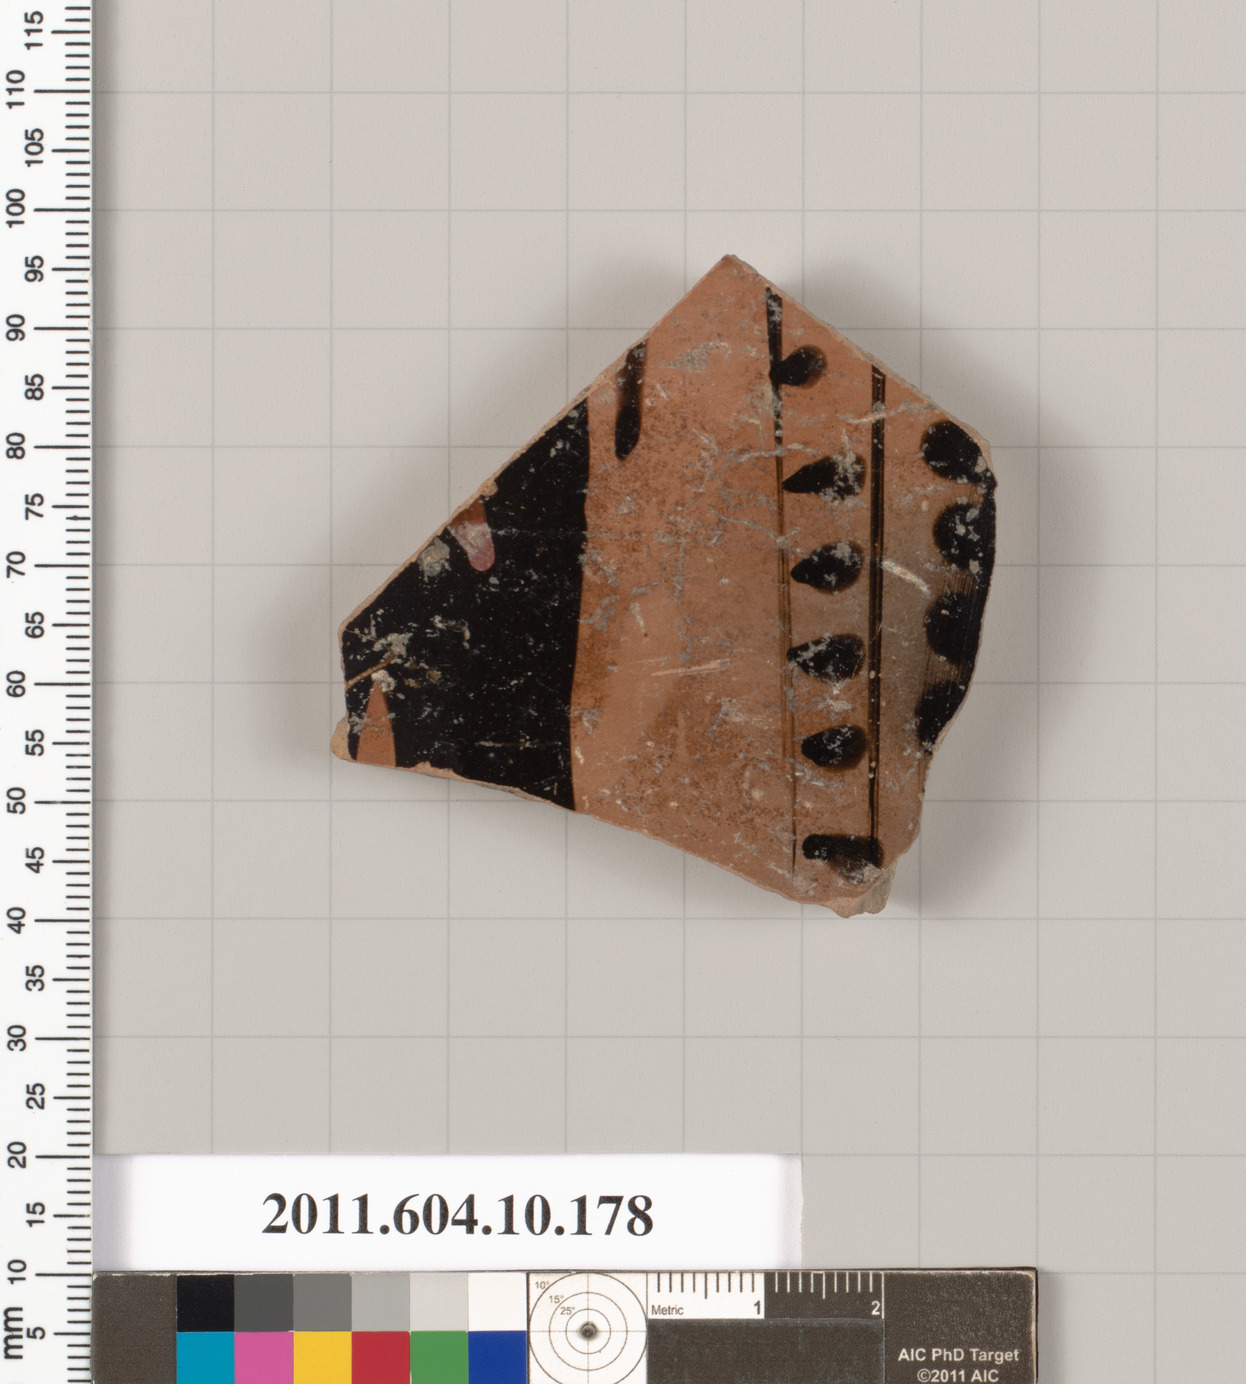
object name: krater fragment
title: Terracotta fragment of a column-krater (deep bowl)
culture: etruscan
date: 534-468 BCE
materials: terracotta